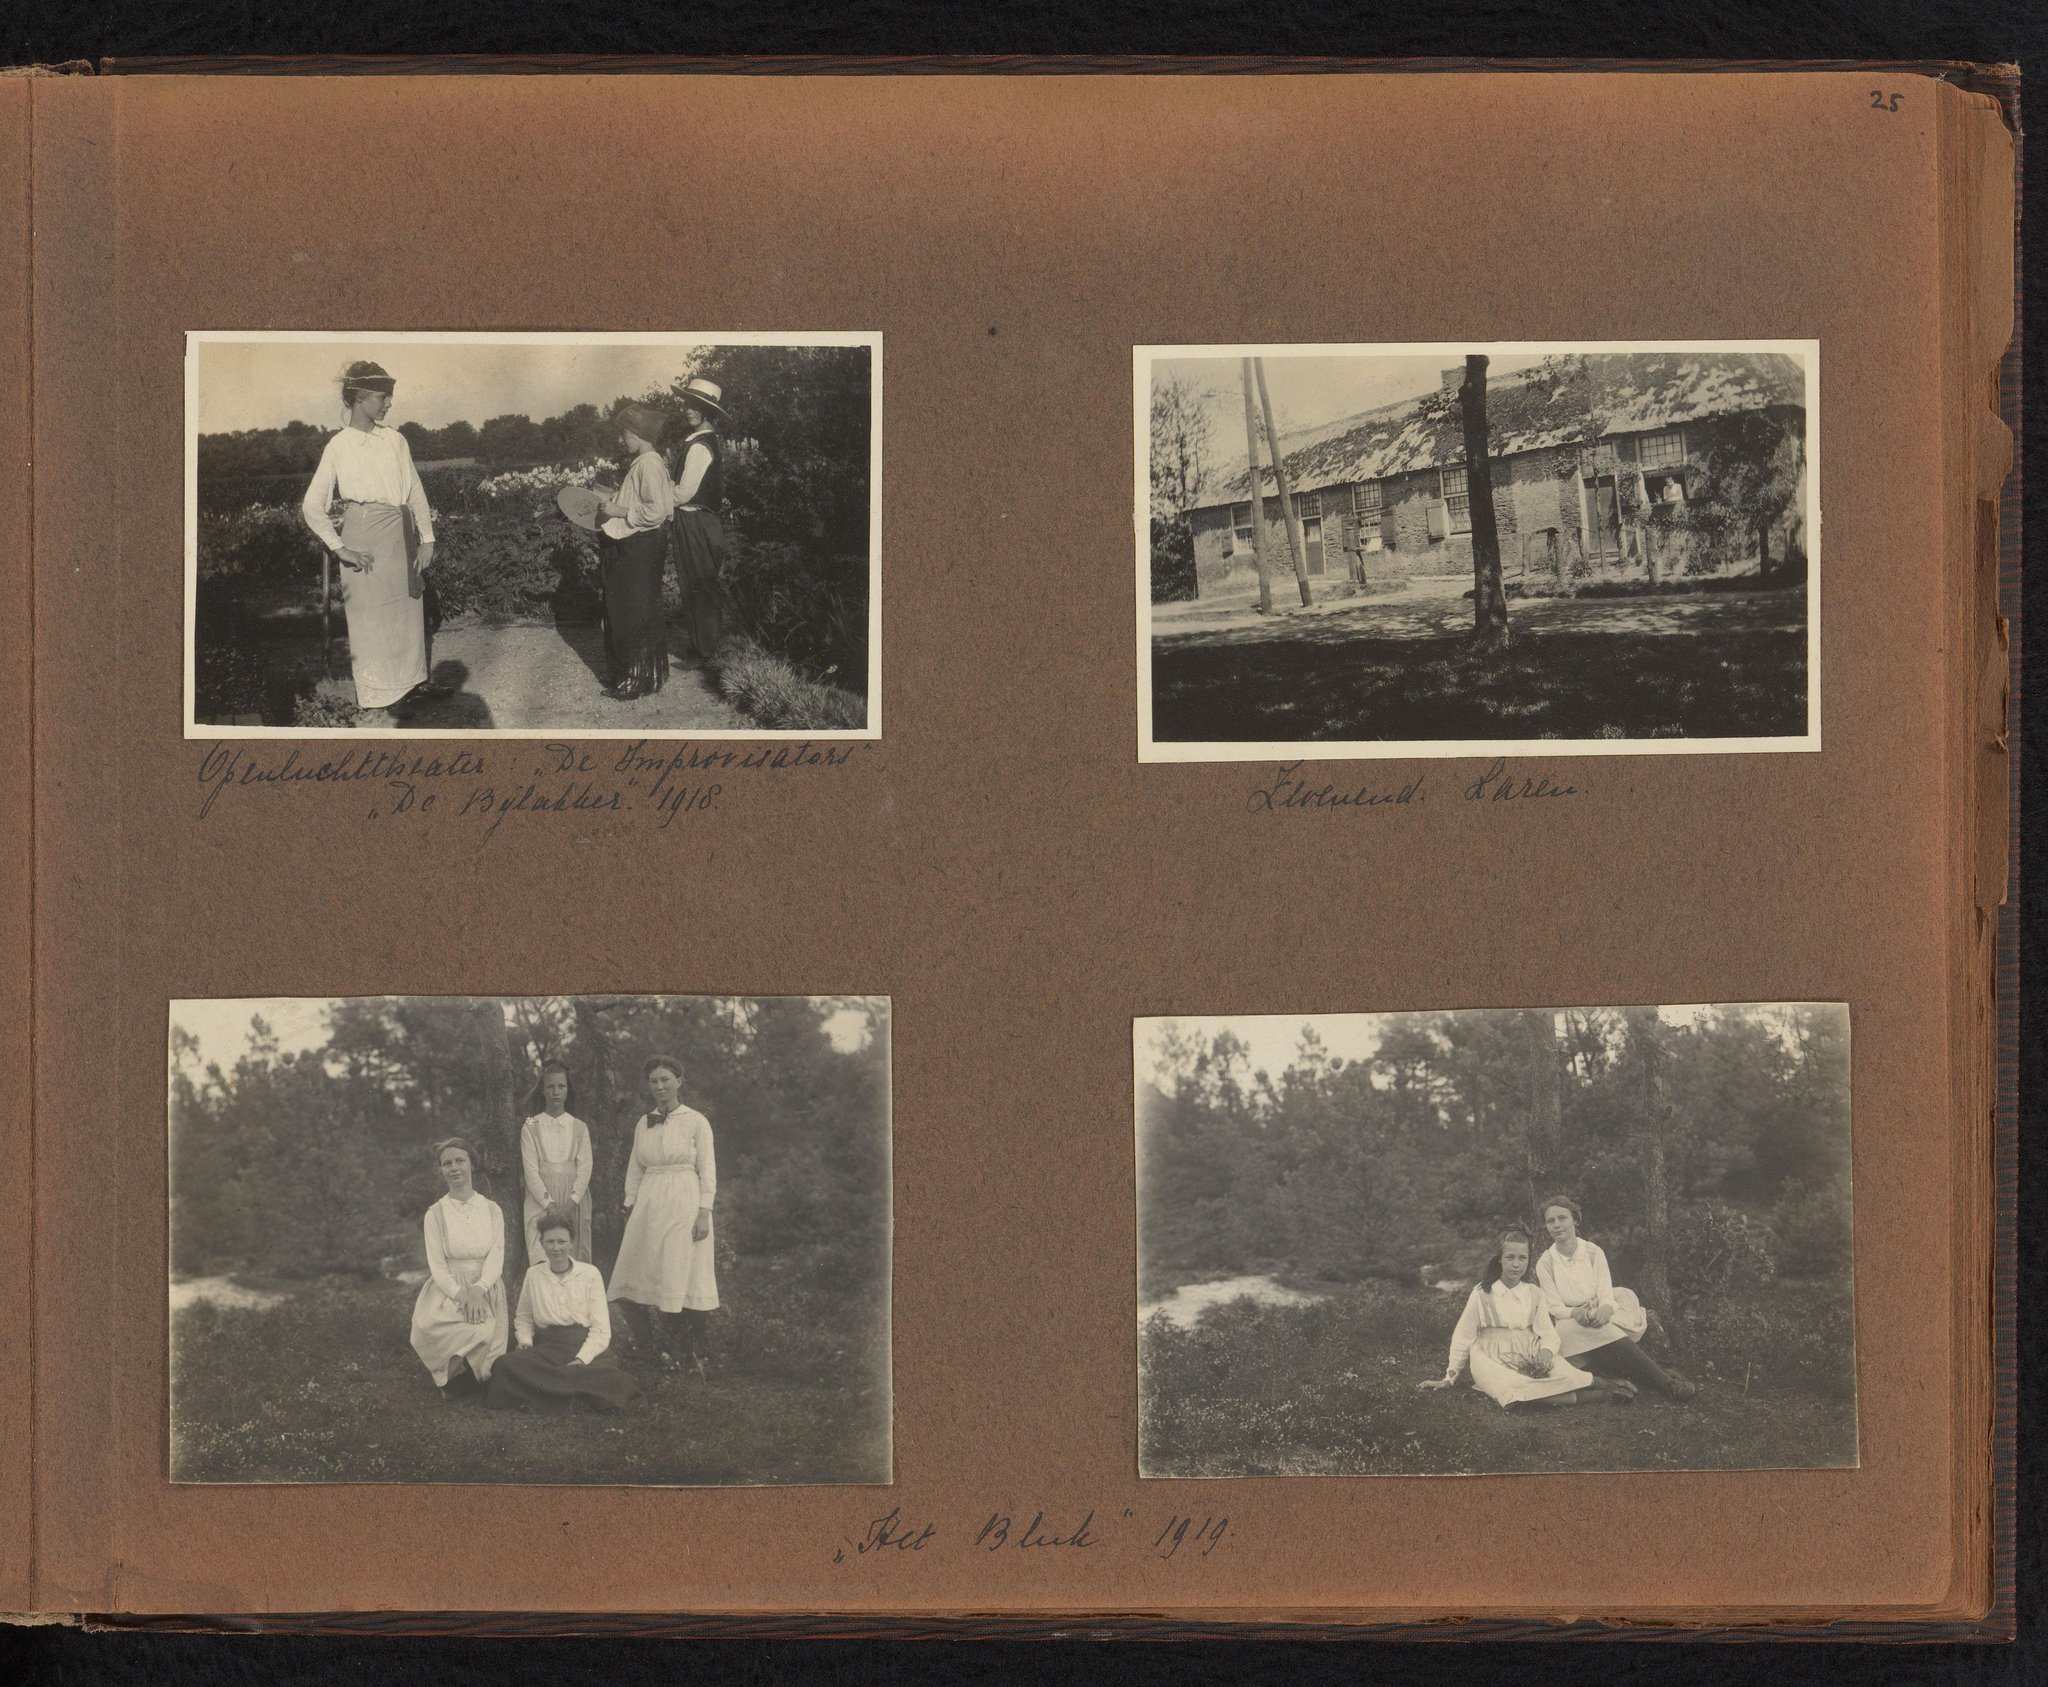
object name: photograph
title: Bladzijde uit het fotoalbum van de familie Diepenbrock met 4 foto's van Alphons Diepenbrock en zijn omgeving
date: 1918-1919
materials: cardboard, photographic support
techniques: photography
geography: amsterdam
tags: laren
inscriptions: inscription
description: Bruin albumblad 25 van familiealbum van Alphons Diepenbrock.